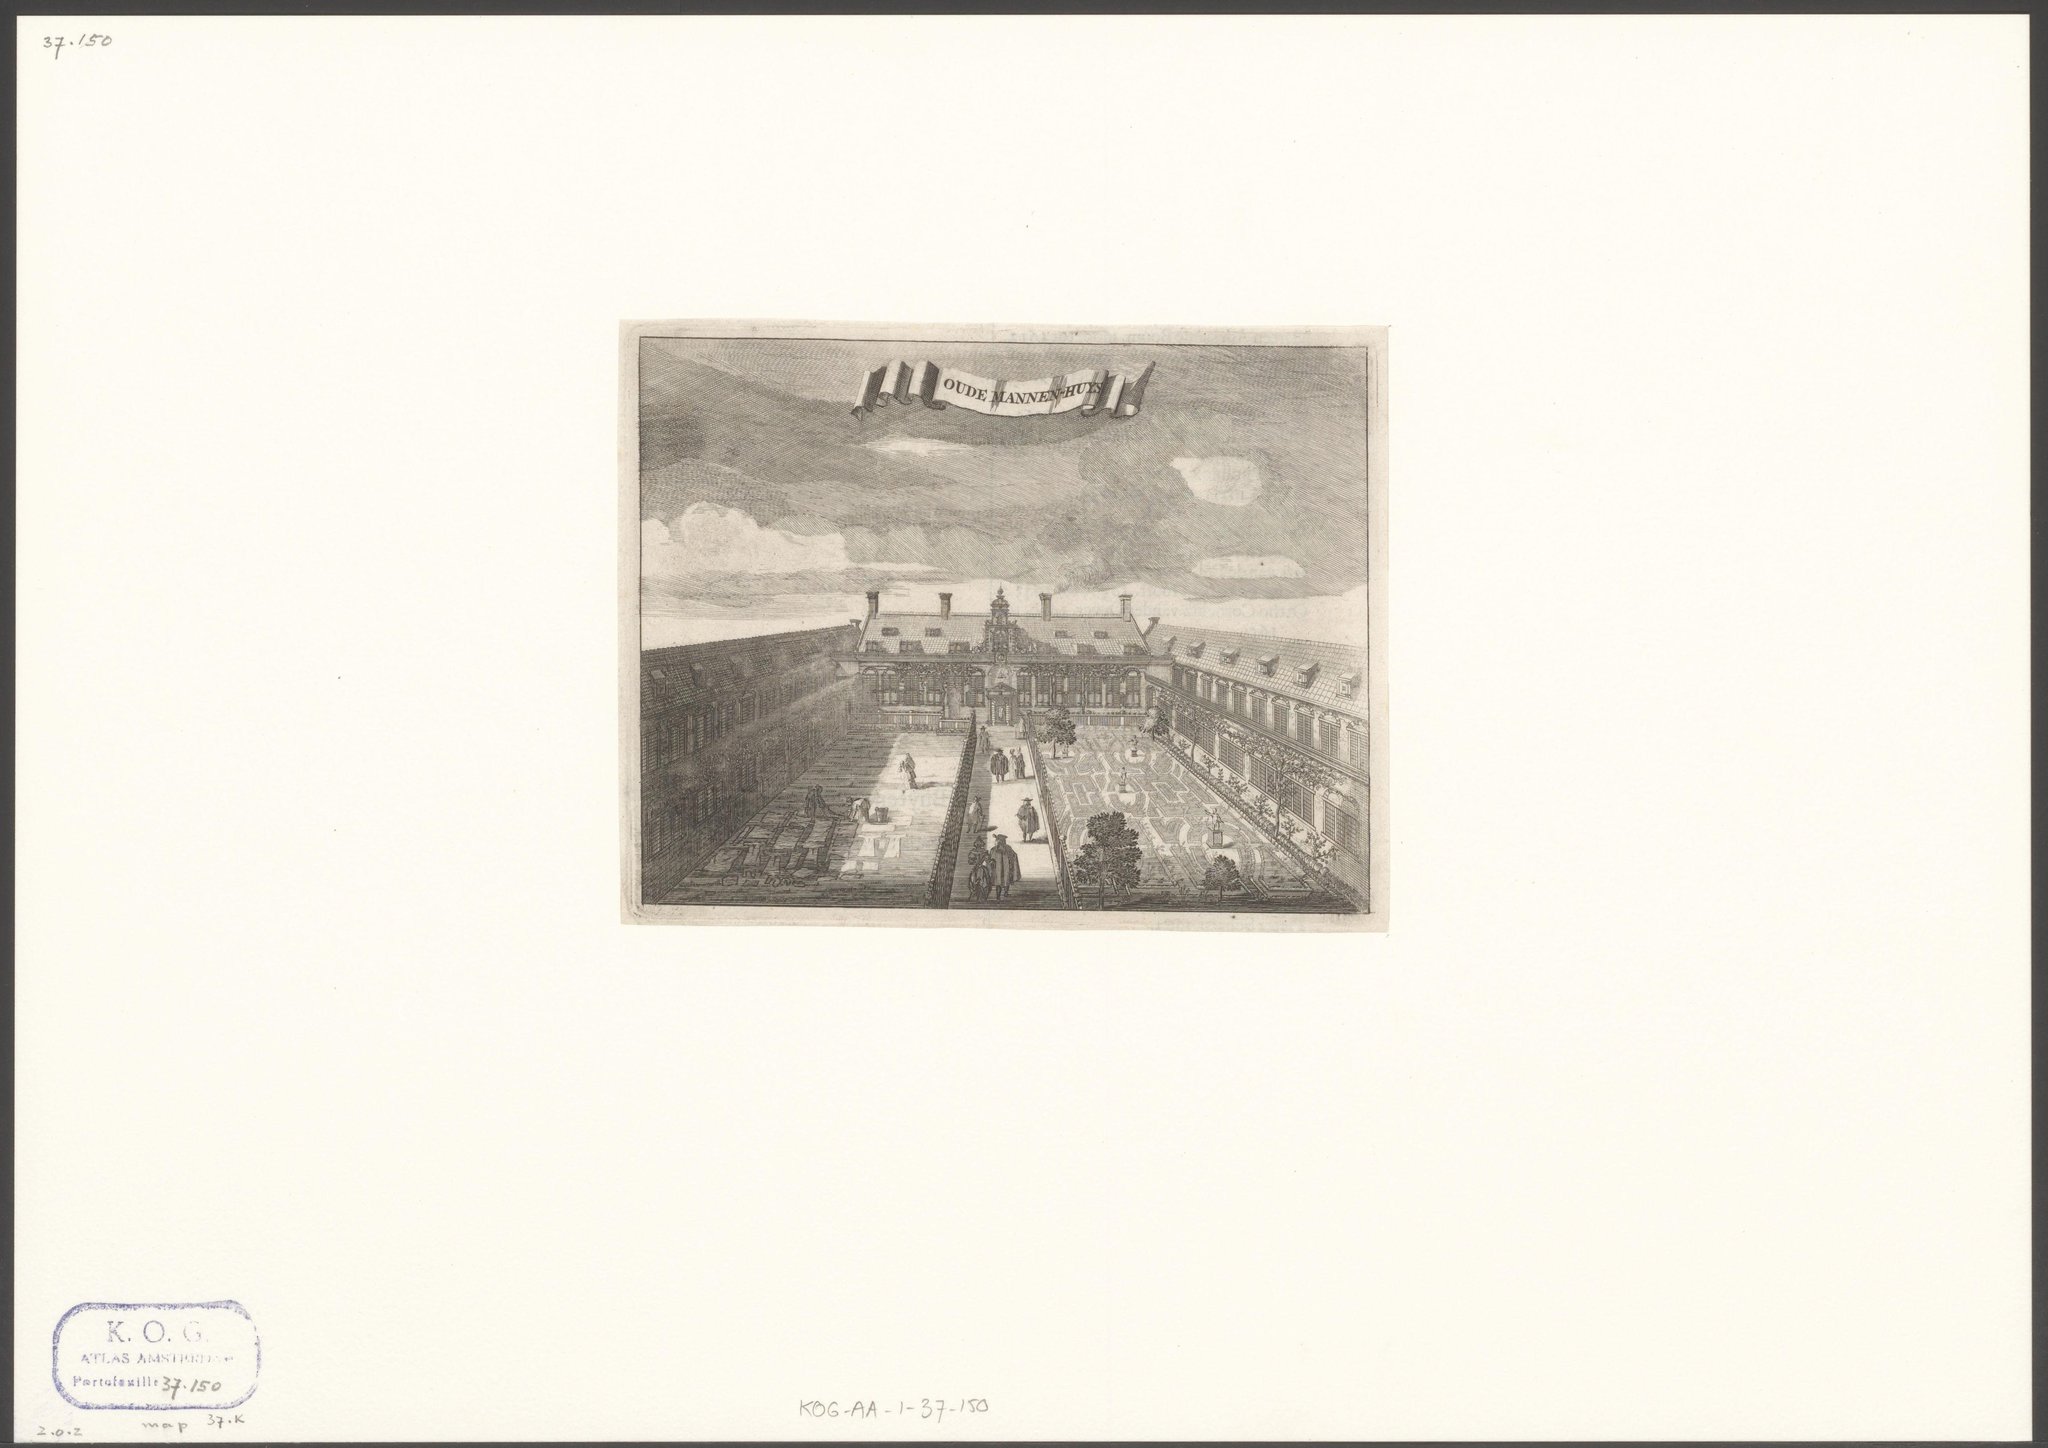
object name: book illustration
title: Gezicht op de binnenplaats van het Oudemannenhuis te Amsterdam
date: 1726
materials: paper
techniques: engraving, etching, letterpress printing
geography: amsterdam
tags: courtyard, old-people's home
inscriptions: collector's mark: Lugt 1641b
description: Prent uit: Commelin, Casparus. Beschryvinge van Amsterdam (…). 2de druk. Amsterdam: Andries van Damme, Johannes Ratelband, weduwe Antony van Aeltwijk en Hermanus Uytwerf, 1726, dl. 1, p. 570.